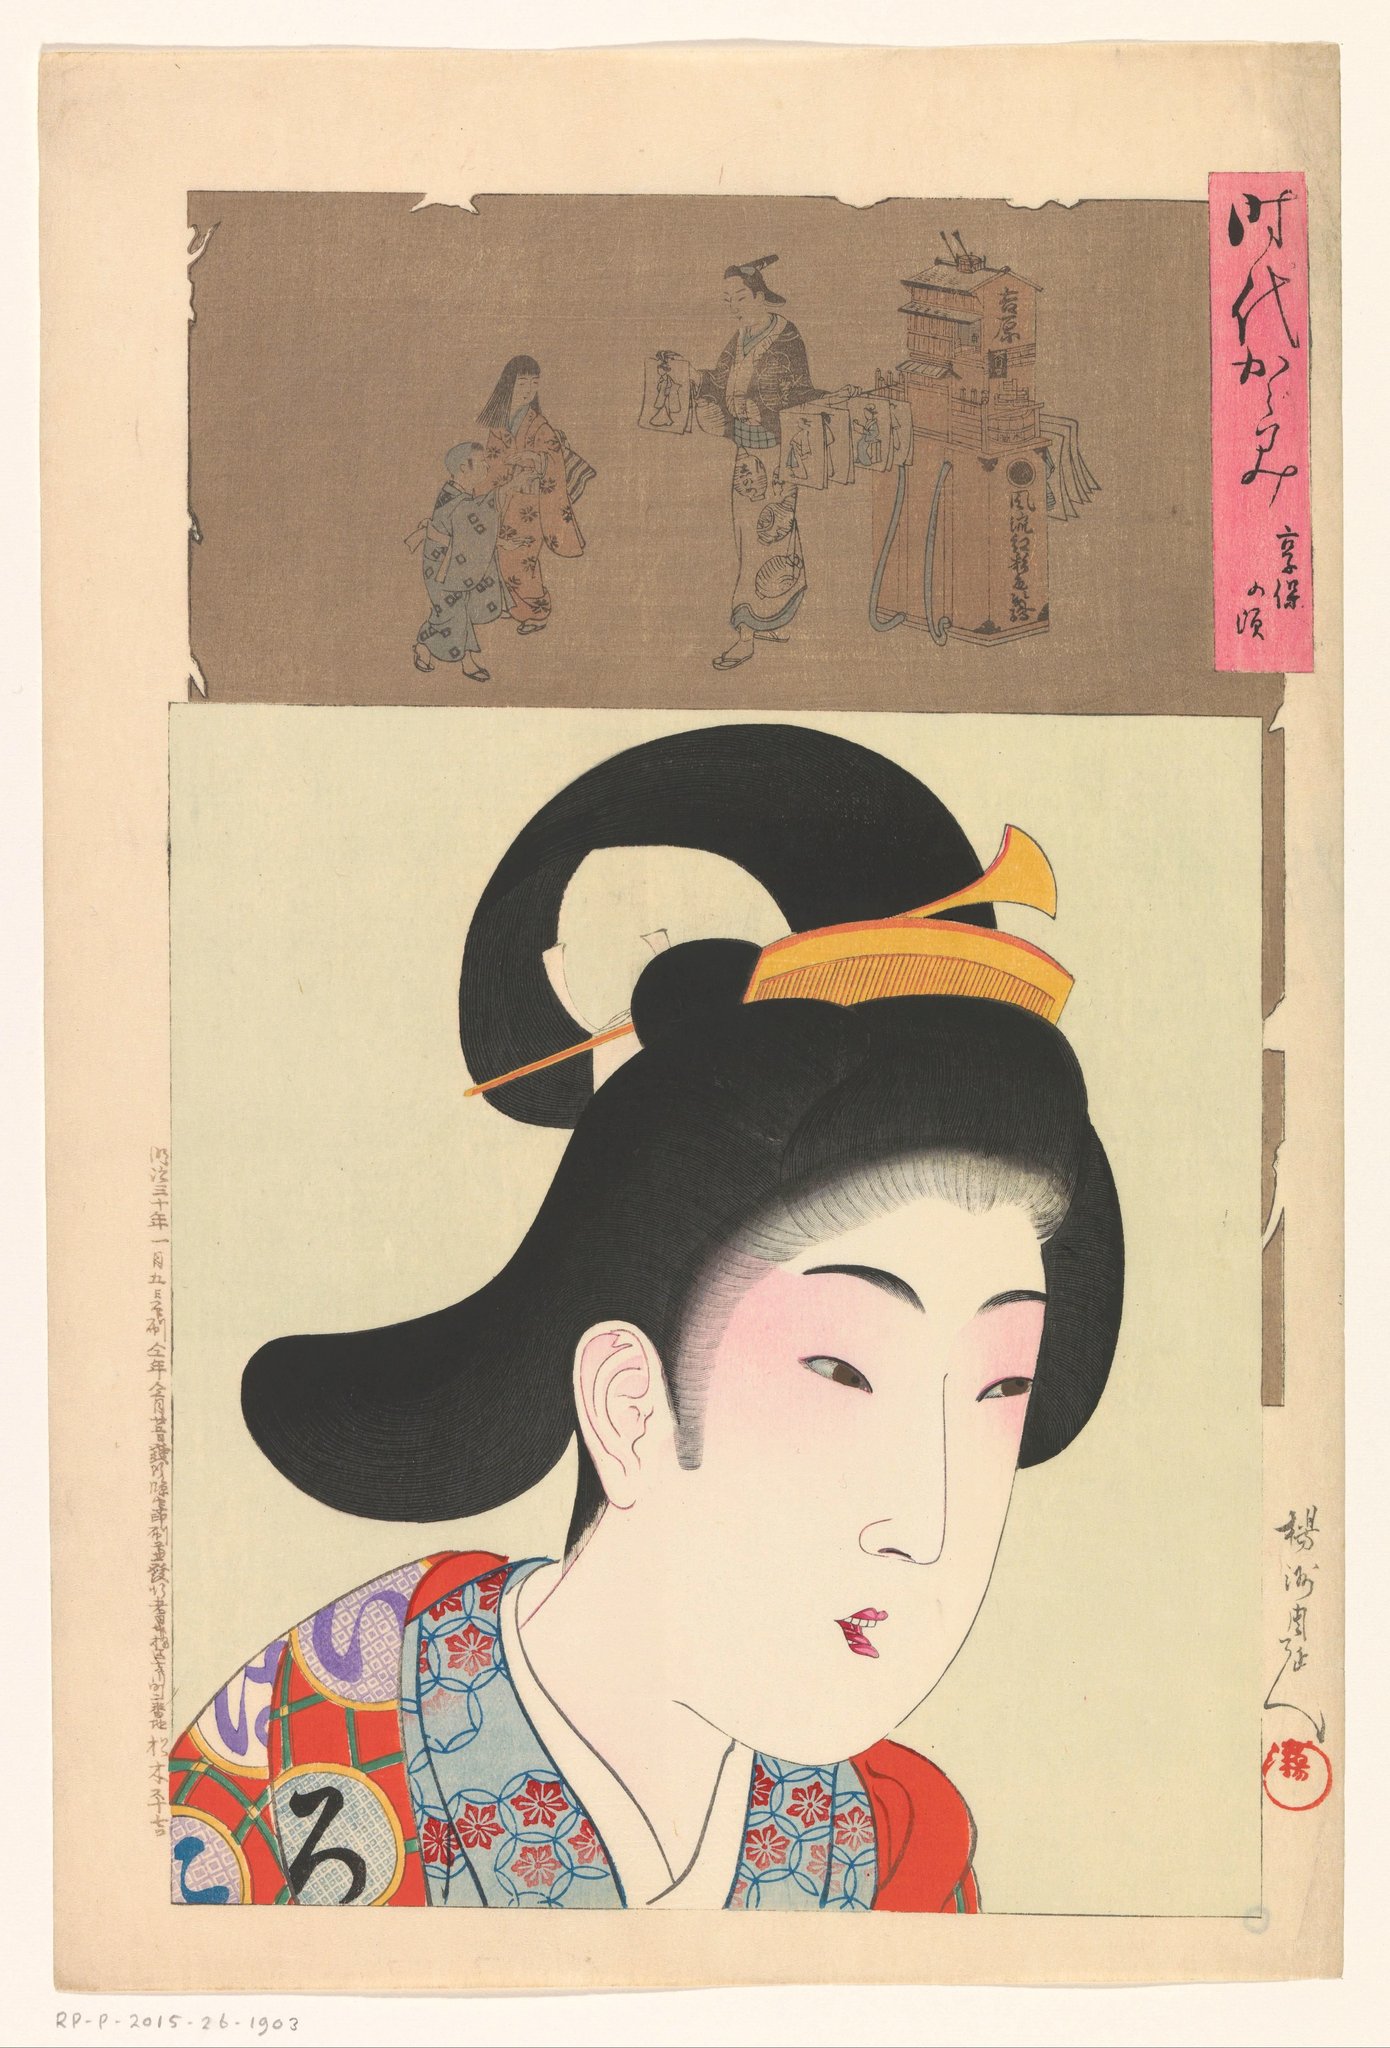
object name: print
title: Portret van een vrouw en een prenthandelaar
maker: toyohara chikanobu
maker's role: print maker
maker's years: 1838-1912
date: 1848-1912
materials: paper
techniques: woodcut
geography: japan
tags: art dealer (+ graphic arts)